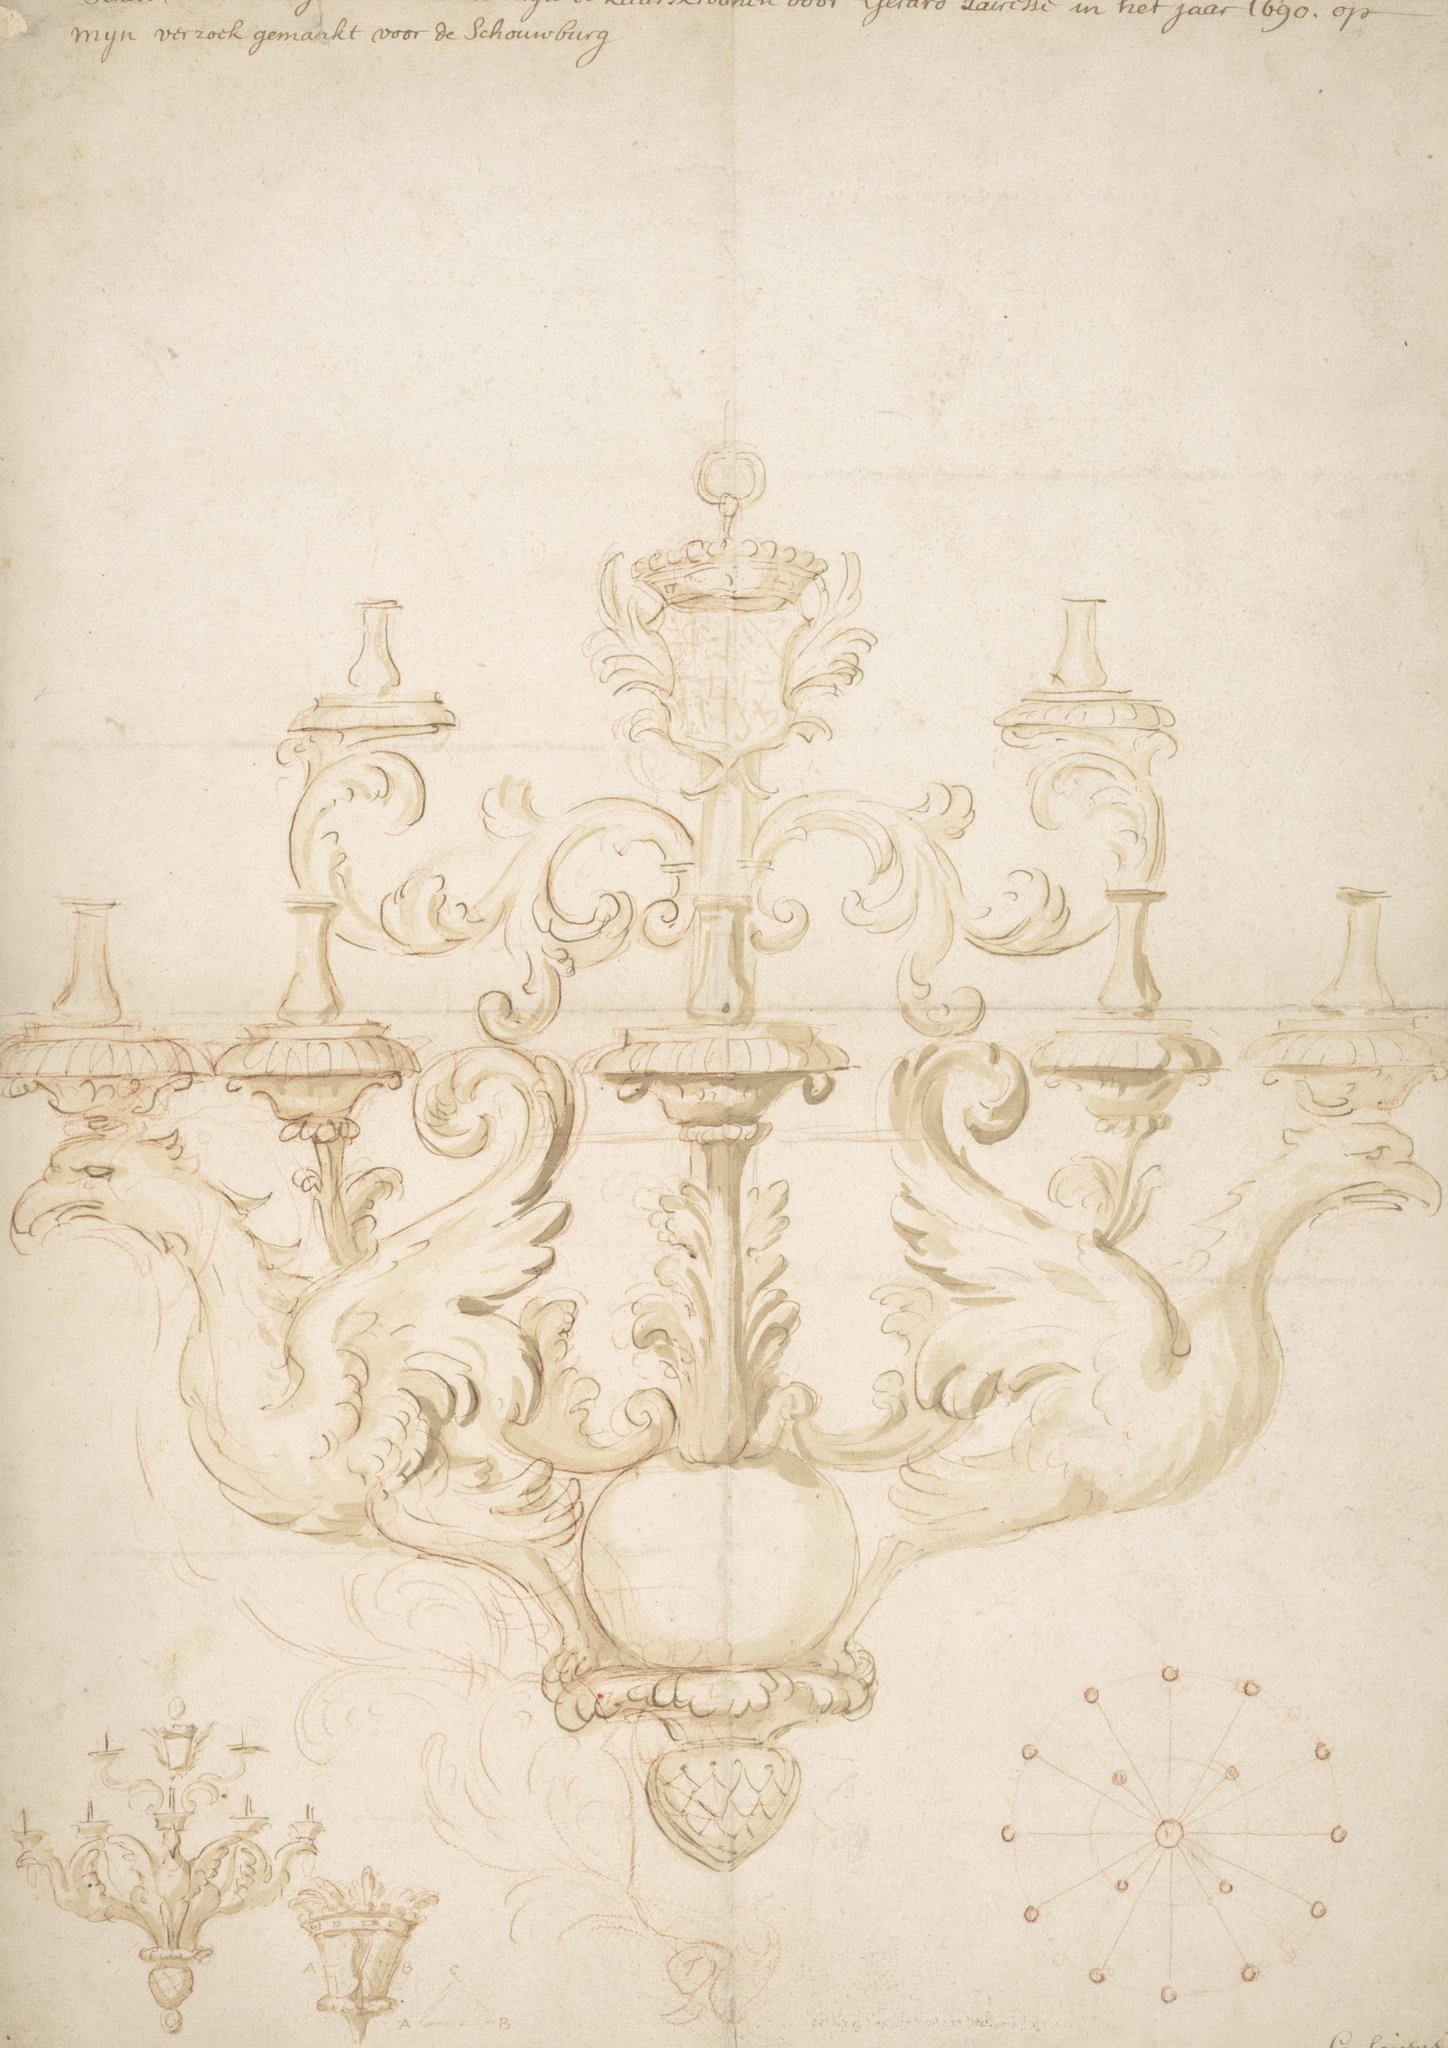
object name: print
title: Berglandschap met wandelaars en hutten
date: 1859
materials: paper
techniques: iris print, lithograph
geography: paris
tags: mountain-range, snow peaks, hut, cabin, lodge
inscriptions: check stamp: Lugt 1090